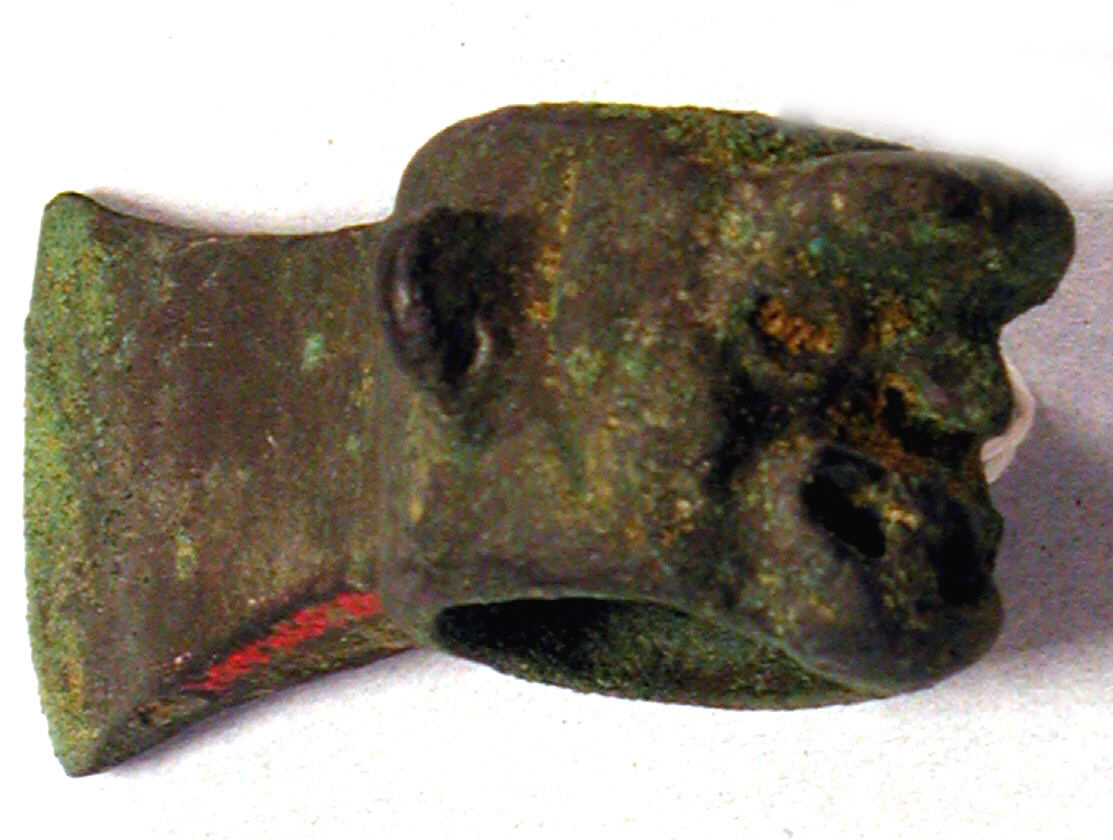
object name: axe blade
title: Copper Axe with Head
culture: peruvian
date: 401-1500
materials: copper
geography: peru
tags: weapons